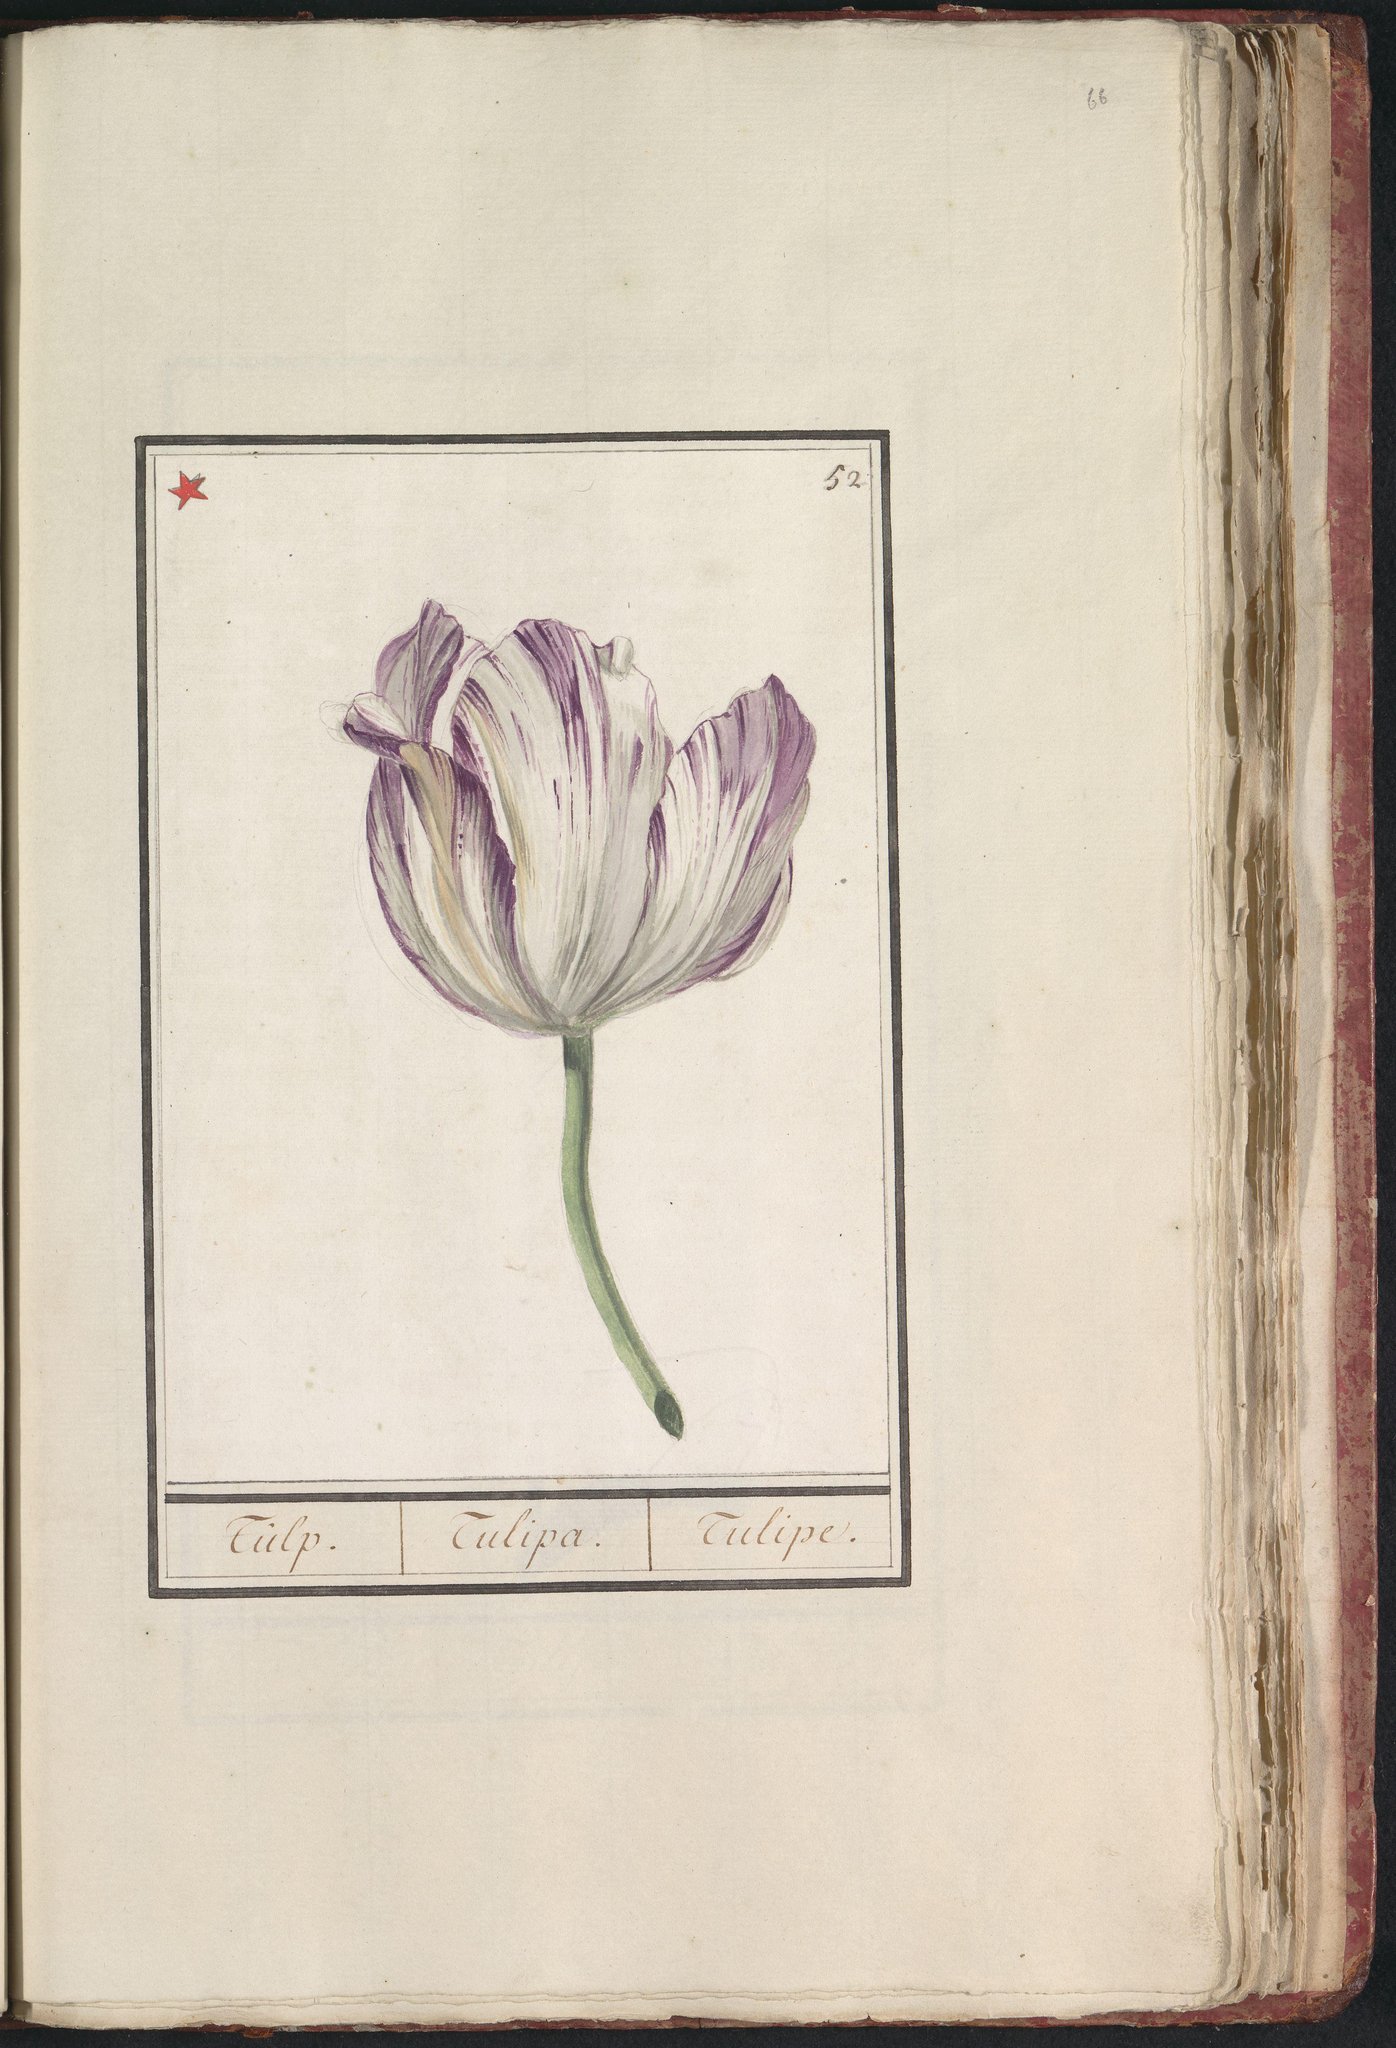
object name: drawing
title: Tulp (Tulipa)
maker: Anonymous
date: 1790-1814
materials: paint, paper, pencil, watercolor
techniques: brush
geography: southern netherlands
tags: flowers: tulip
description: Paars-witte tulp. Genummerd rechtsboven: 52. Linksboven gemerkt met een rood sterretje. Onderdeel van het eerste album met tekeningen van bloemen en planten. Achtste van twaalf albums met tekeningen van dieren, vogels en planten bekend rond 1600, gemaakt in opdracht van keizer Rudolf II. Met toelichting in Nederlands, Latijn en Frans.